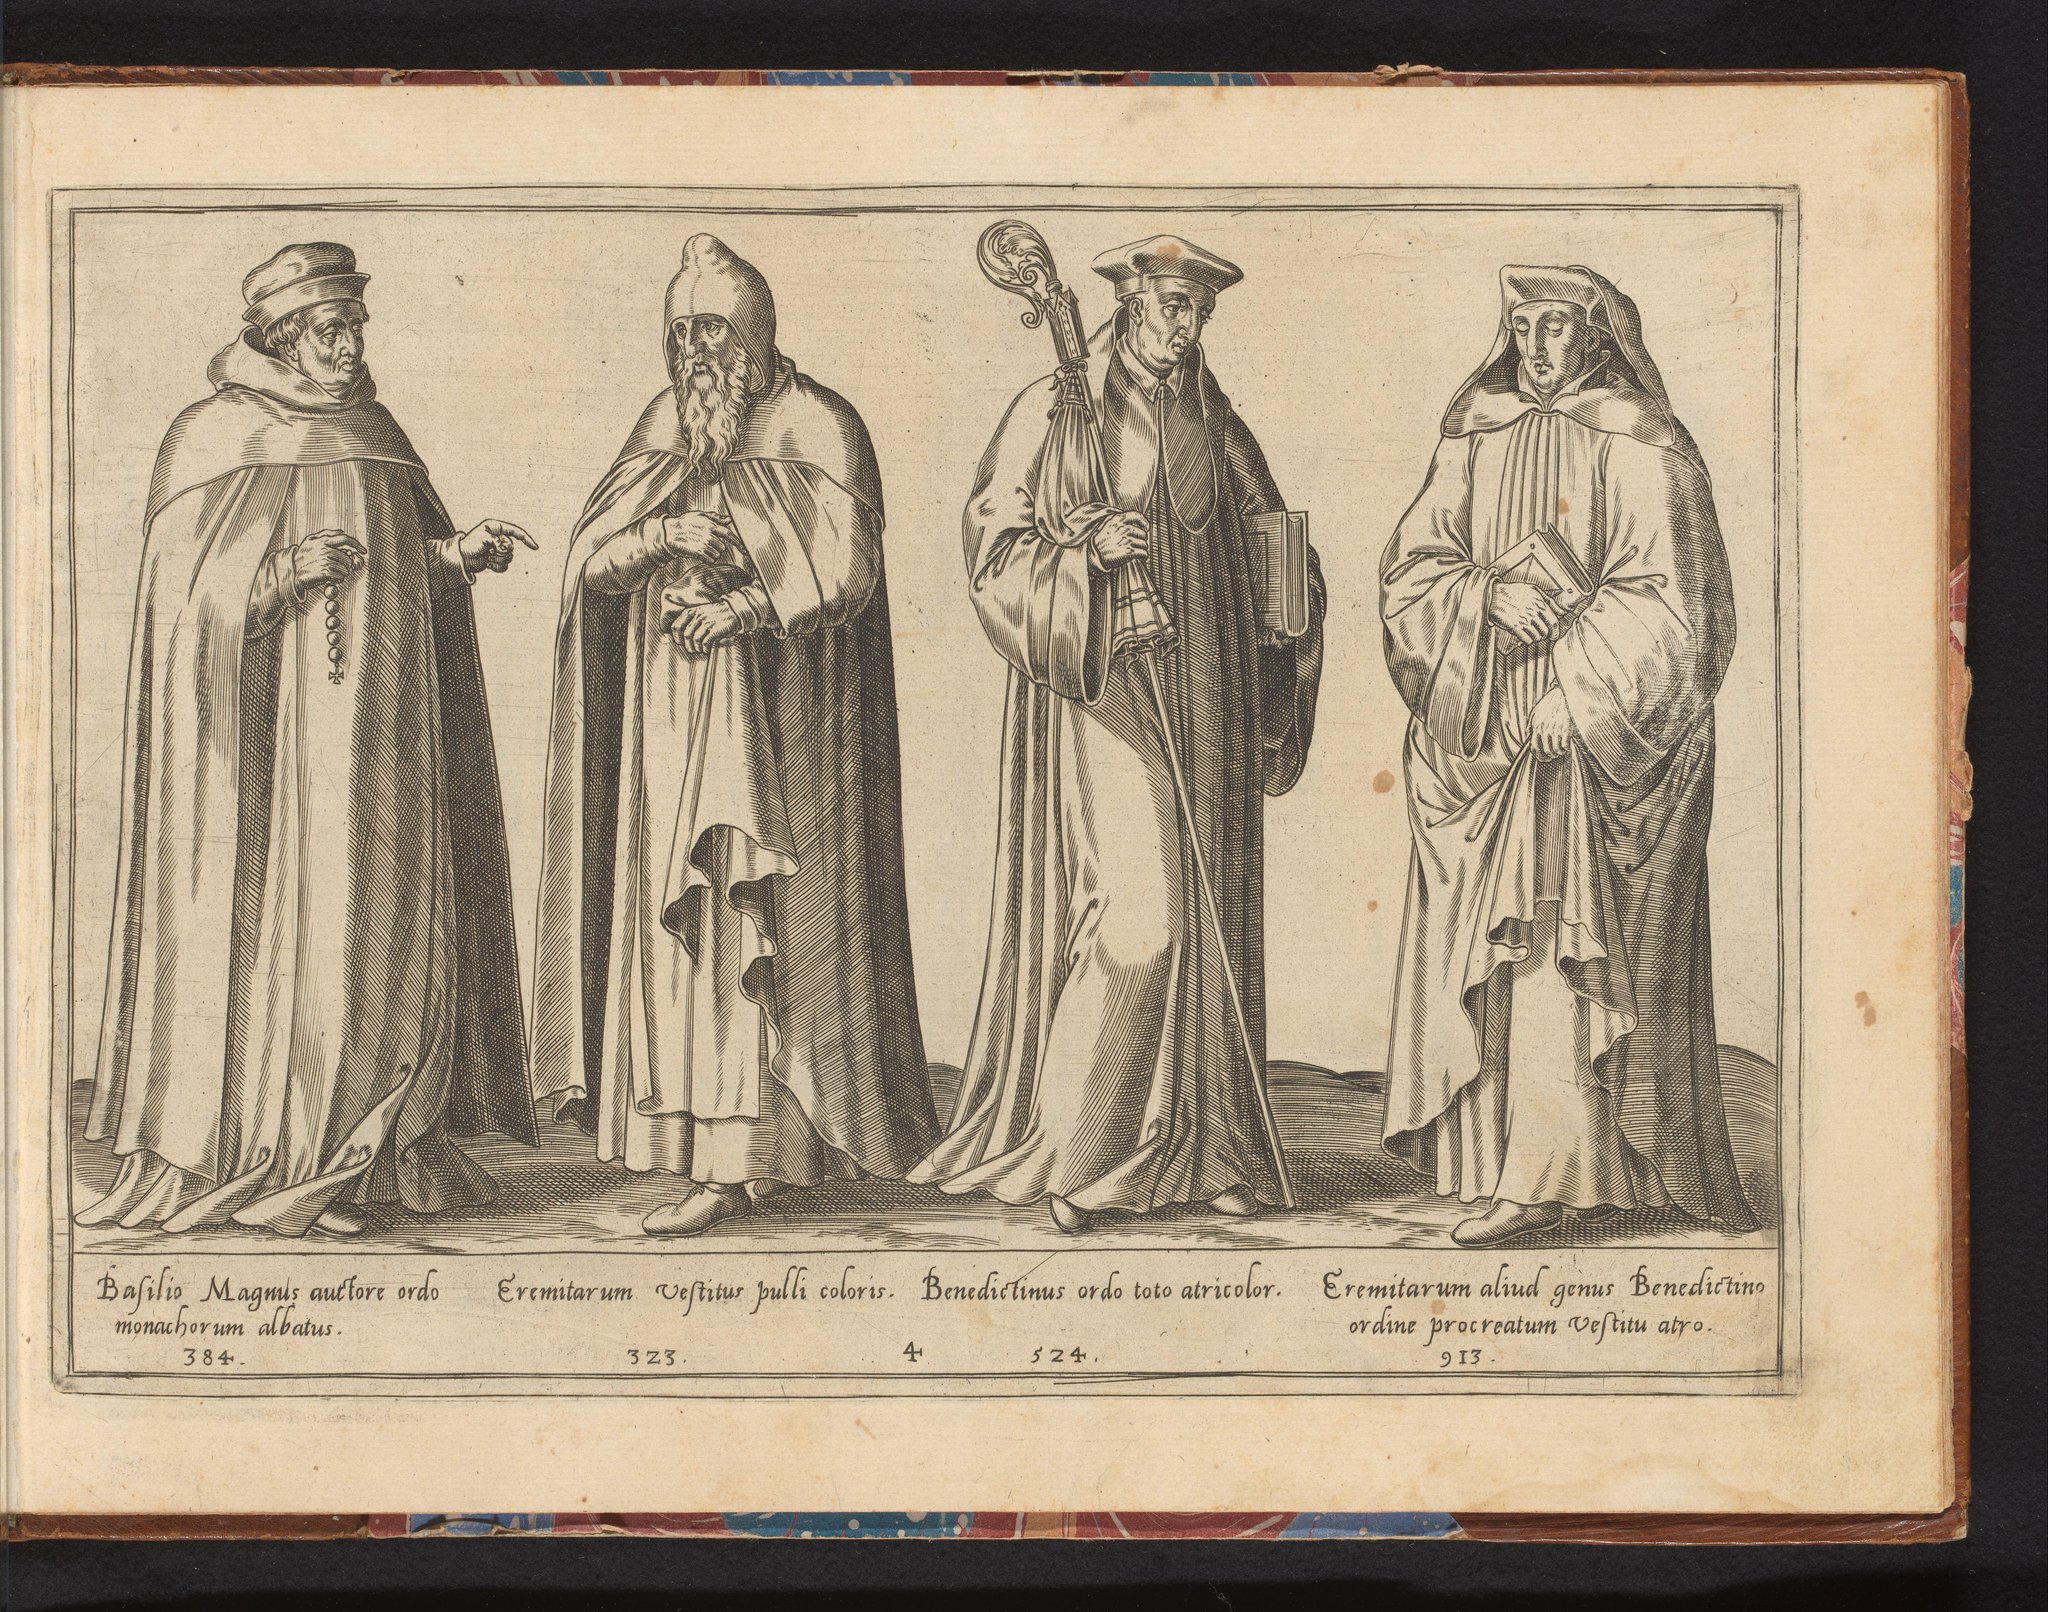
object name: costume print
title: Vier monniken uit verschillende orden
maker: abraham de bruyn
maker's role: print maker, publisher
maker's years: 1540-1587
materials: paper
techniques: engraving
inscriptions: number: ‘4’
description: Prent uit het boek 'Omnium pene Europae, Asiae, Aphricae atque Americae gentium habitus...', 1581. De prent maakt deel uit van een album.